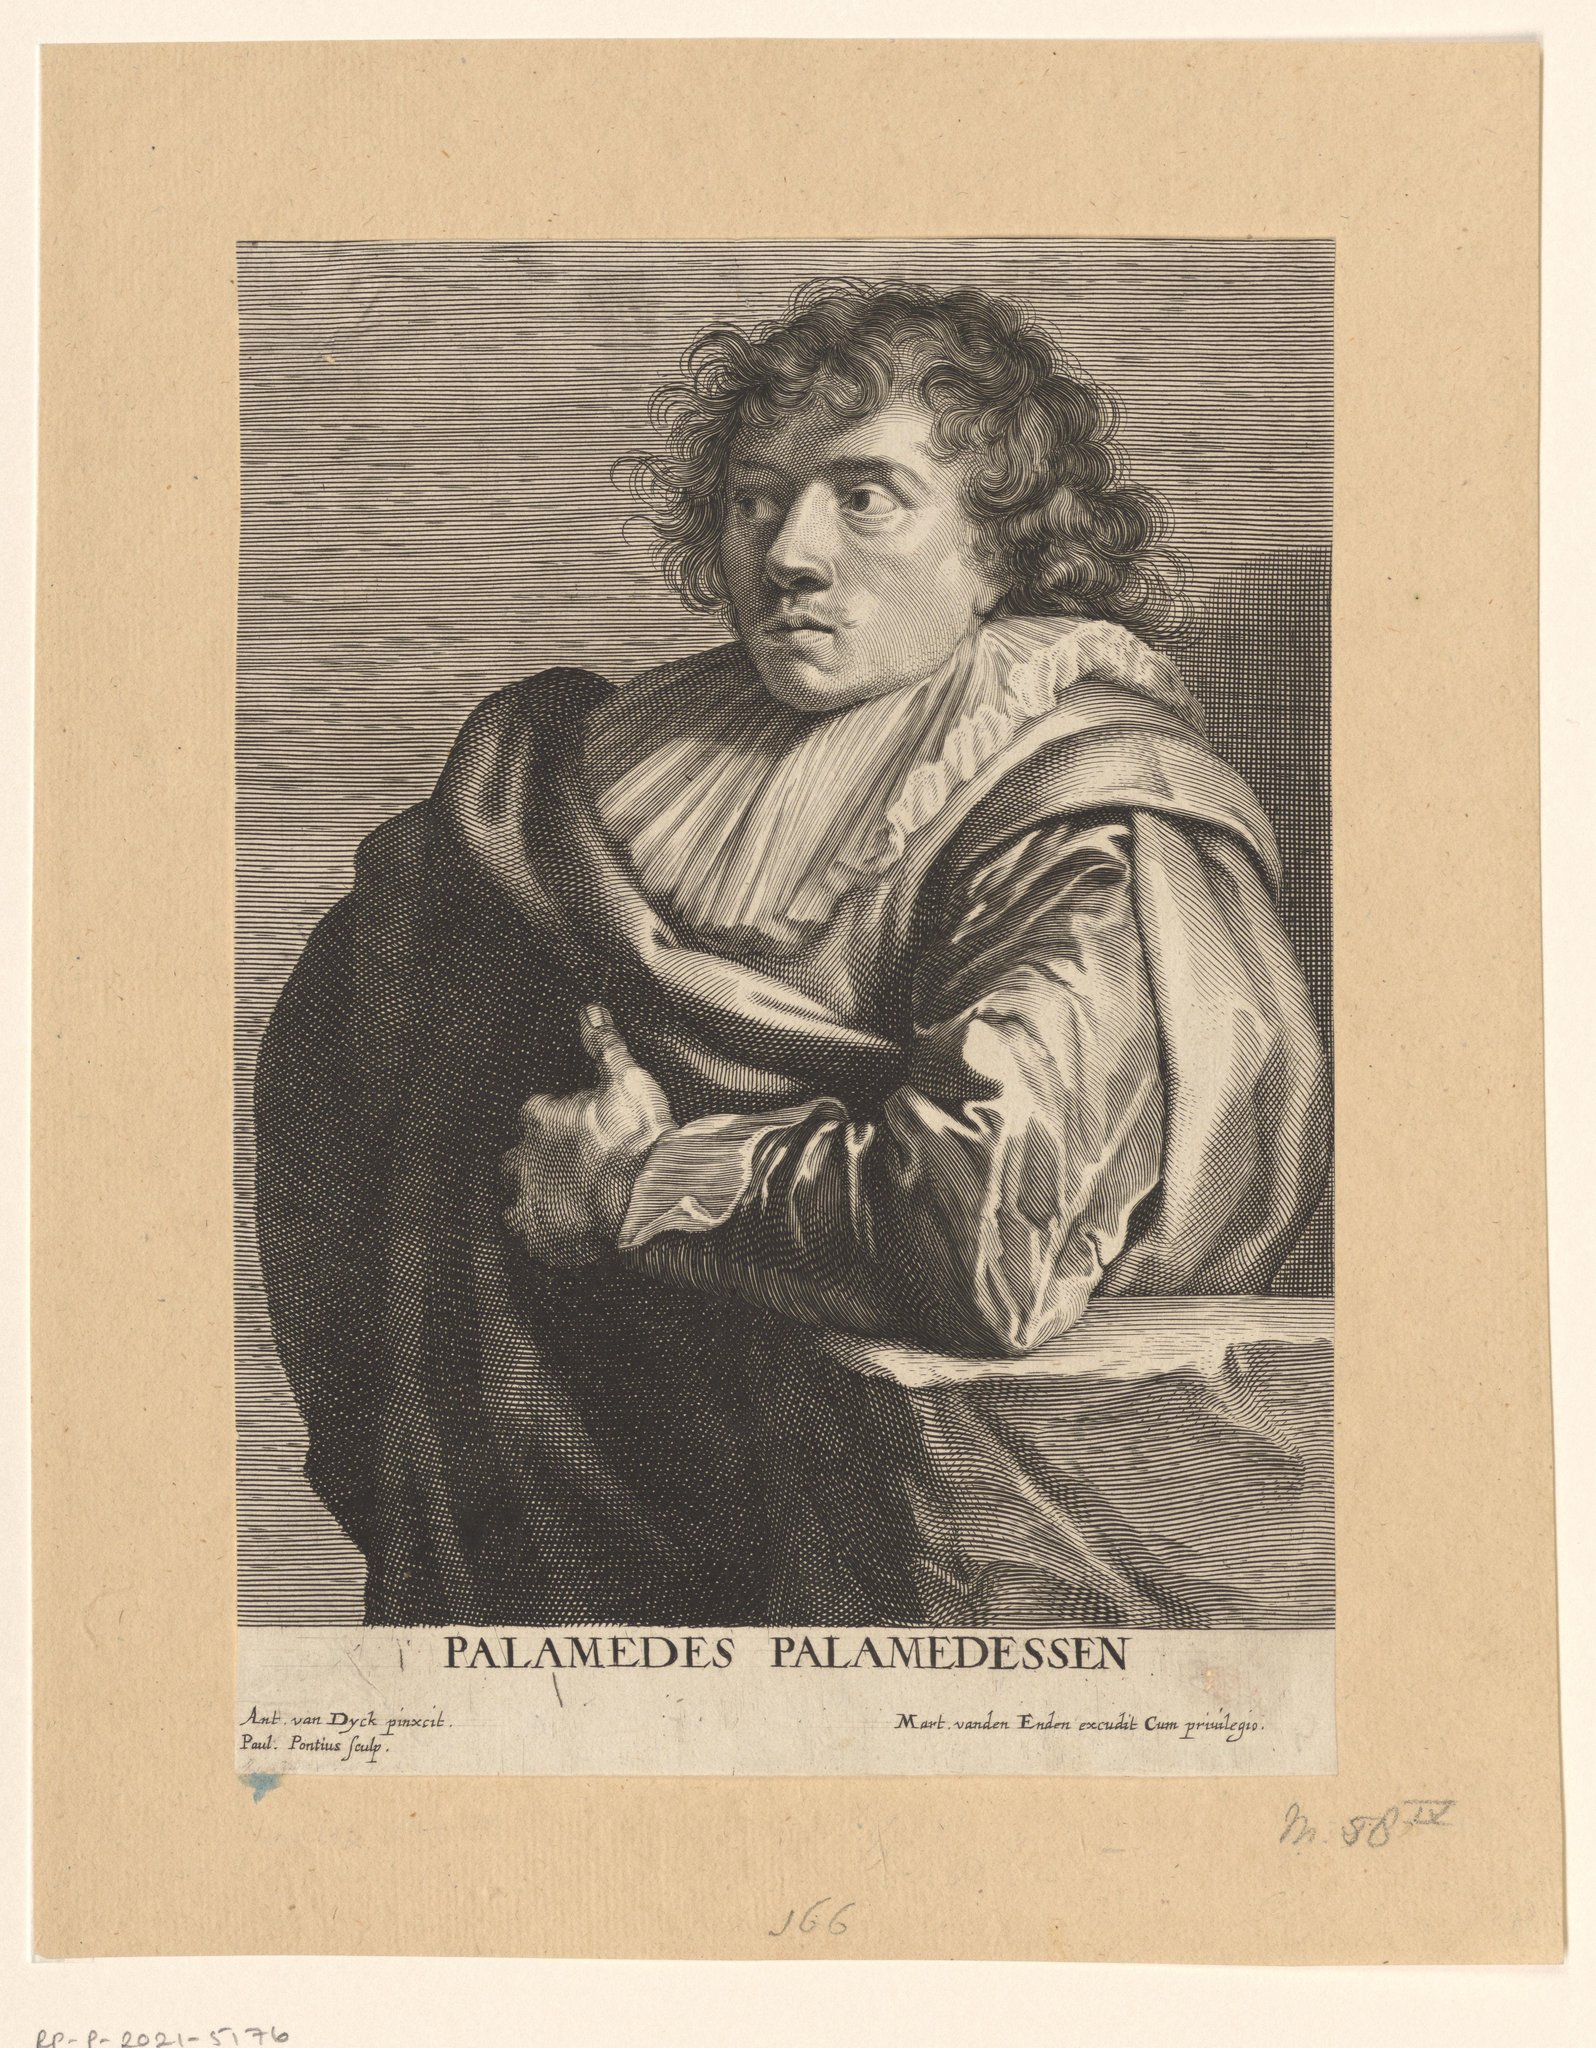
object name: print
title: Portret van Palamedes Palamedesz. I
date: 1630-1654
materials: paper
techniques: engraving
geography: antwerp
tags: delft, painter, palamedes palamedesz. (i), adult man, historical persons, portrait, self-portrait of painter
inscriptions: collector's mark: Lugt 2228